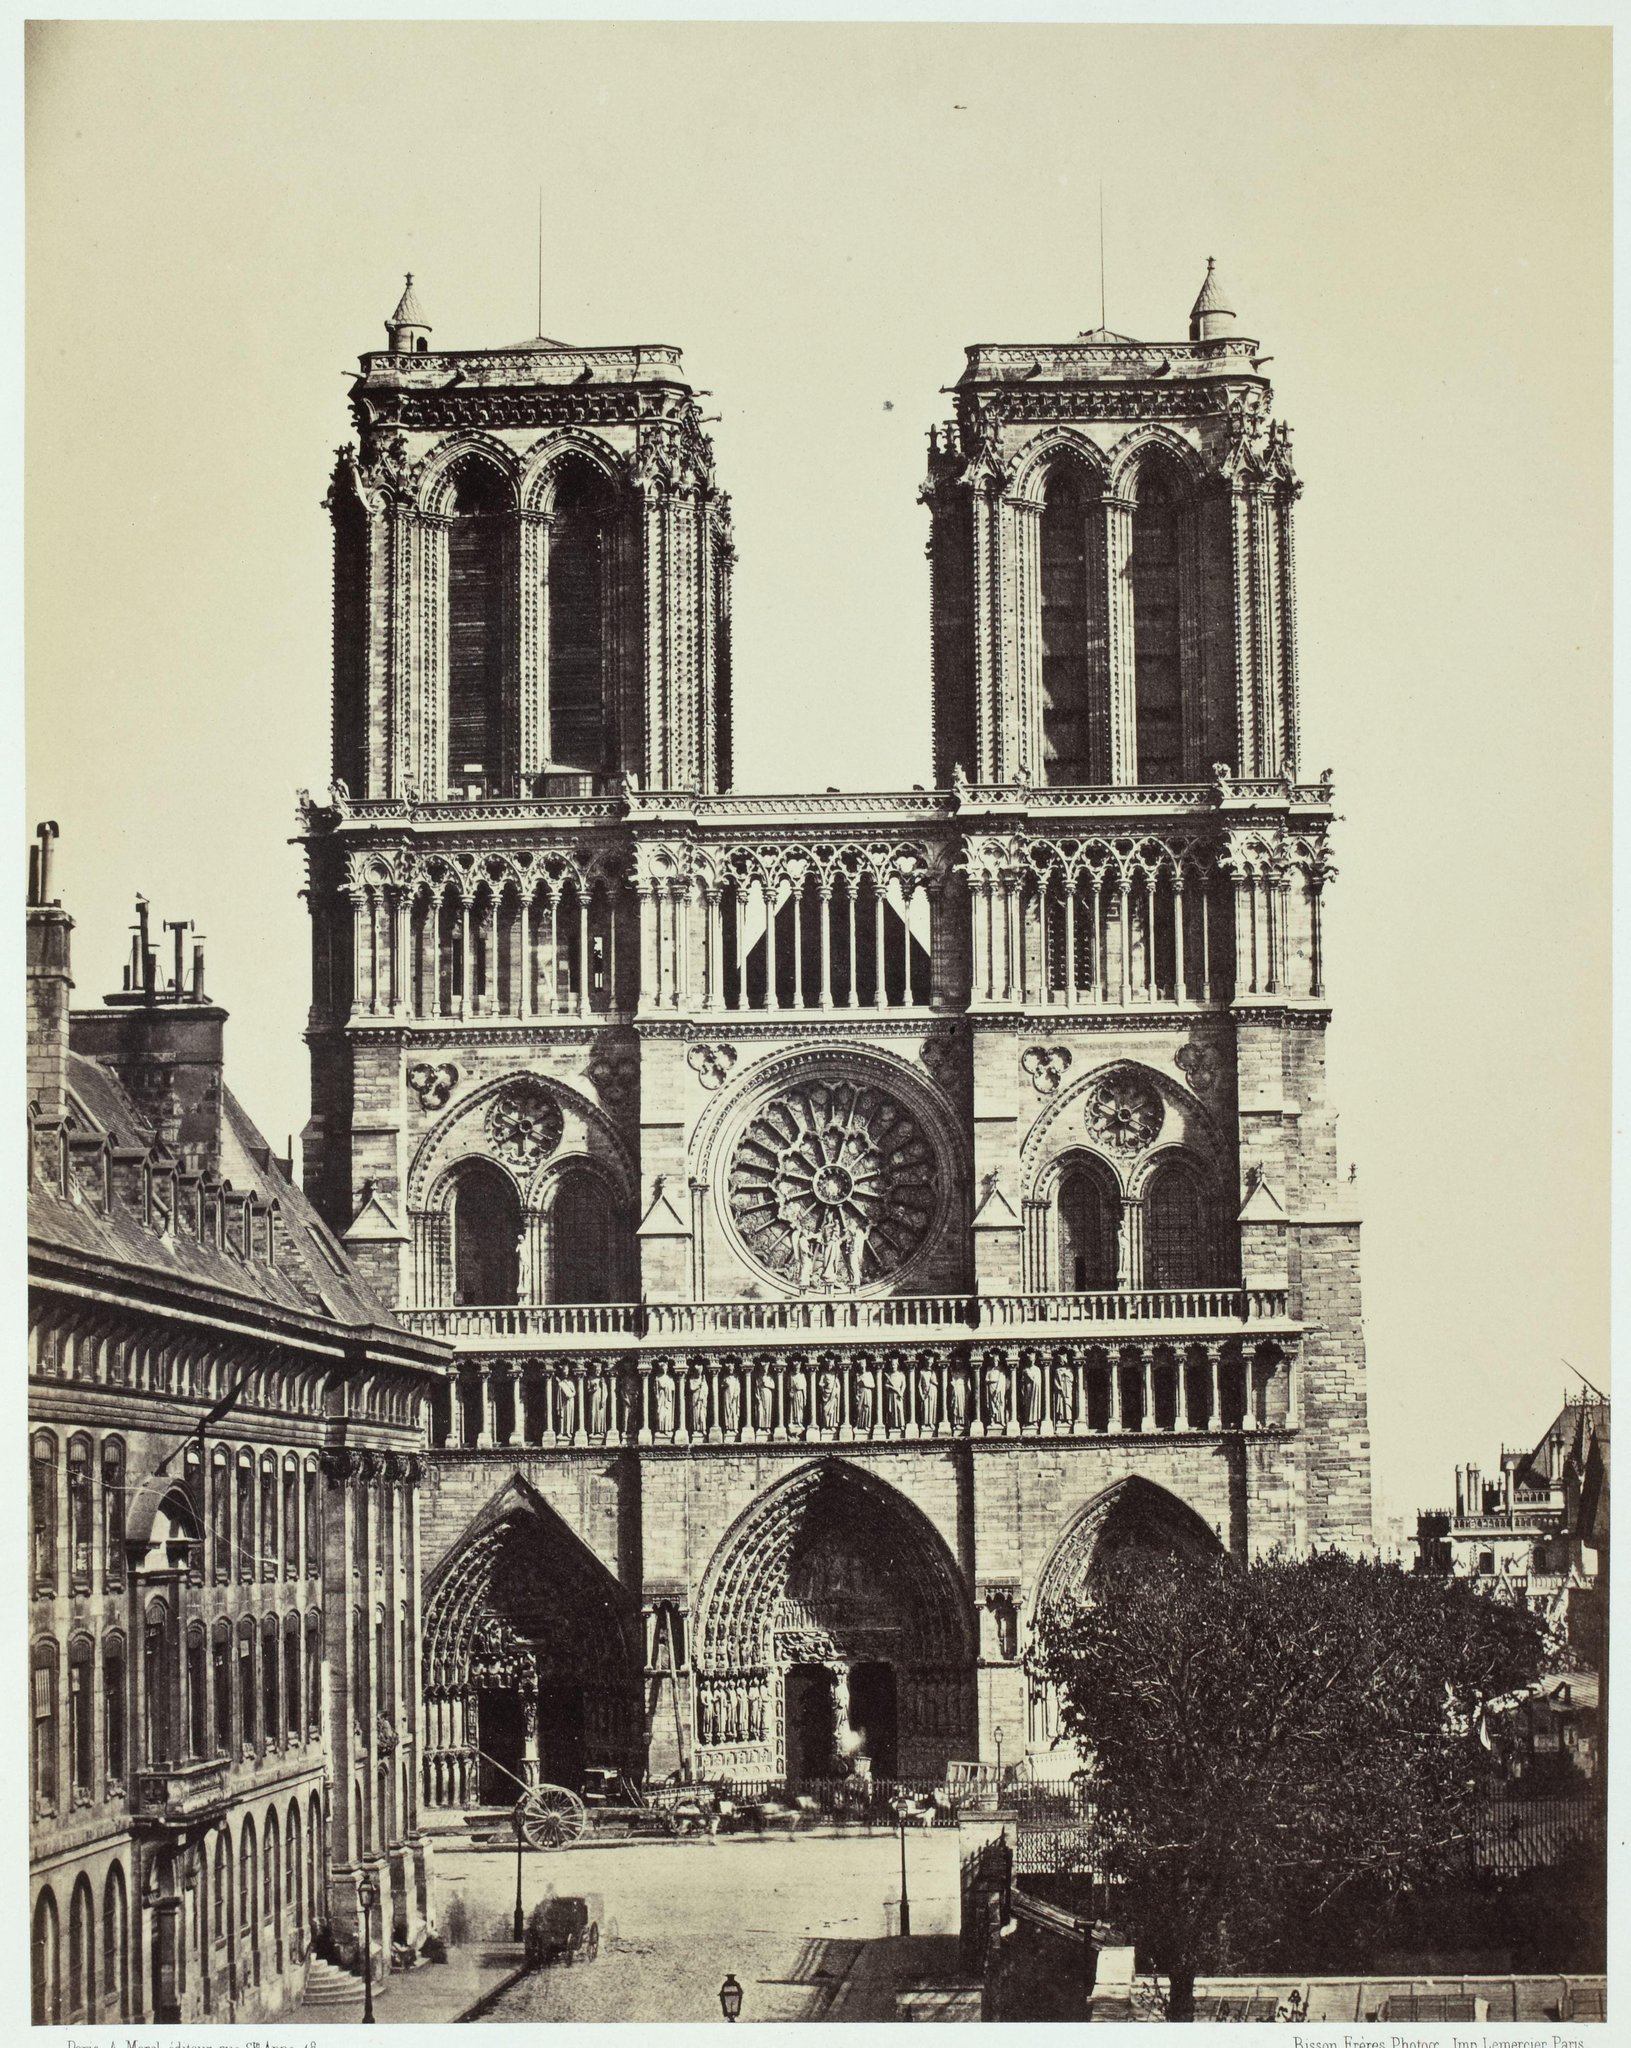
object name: photograph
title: Façade principale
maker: a. morel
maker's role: publisher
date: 1853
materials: cardboard, paper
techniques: albumen print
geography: paris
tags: parts of church exterior and annexes: façade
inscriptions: stamp: ‘Bibliotheek/ Rijksmuseum/ Amsterdam’